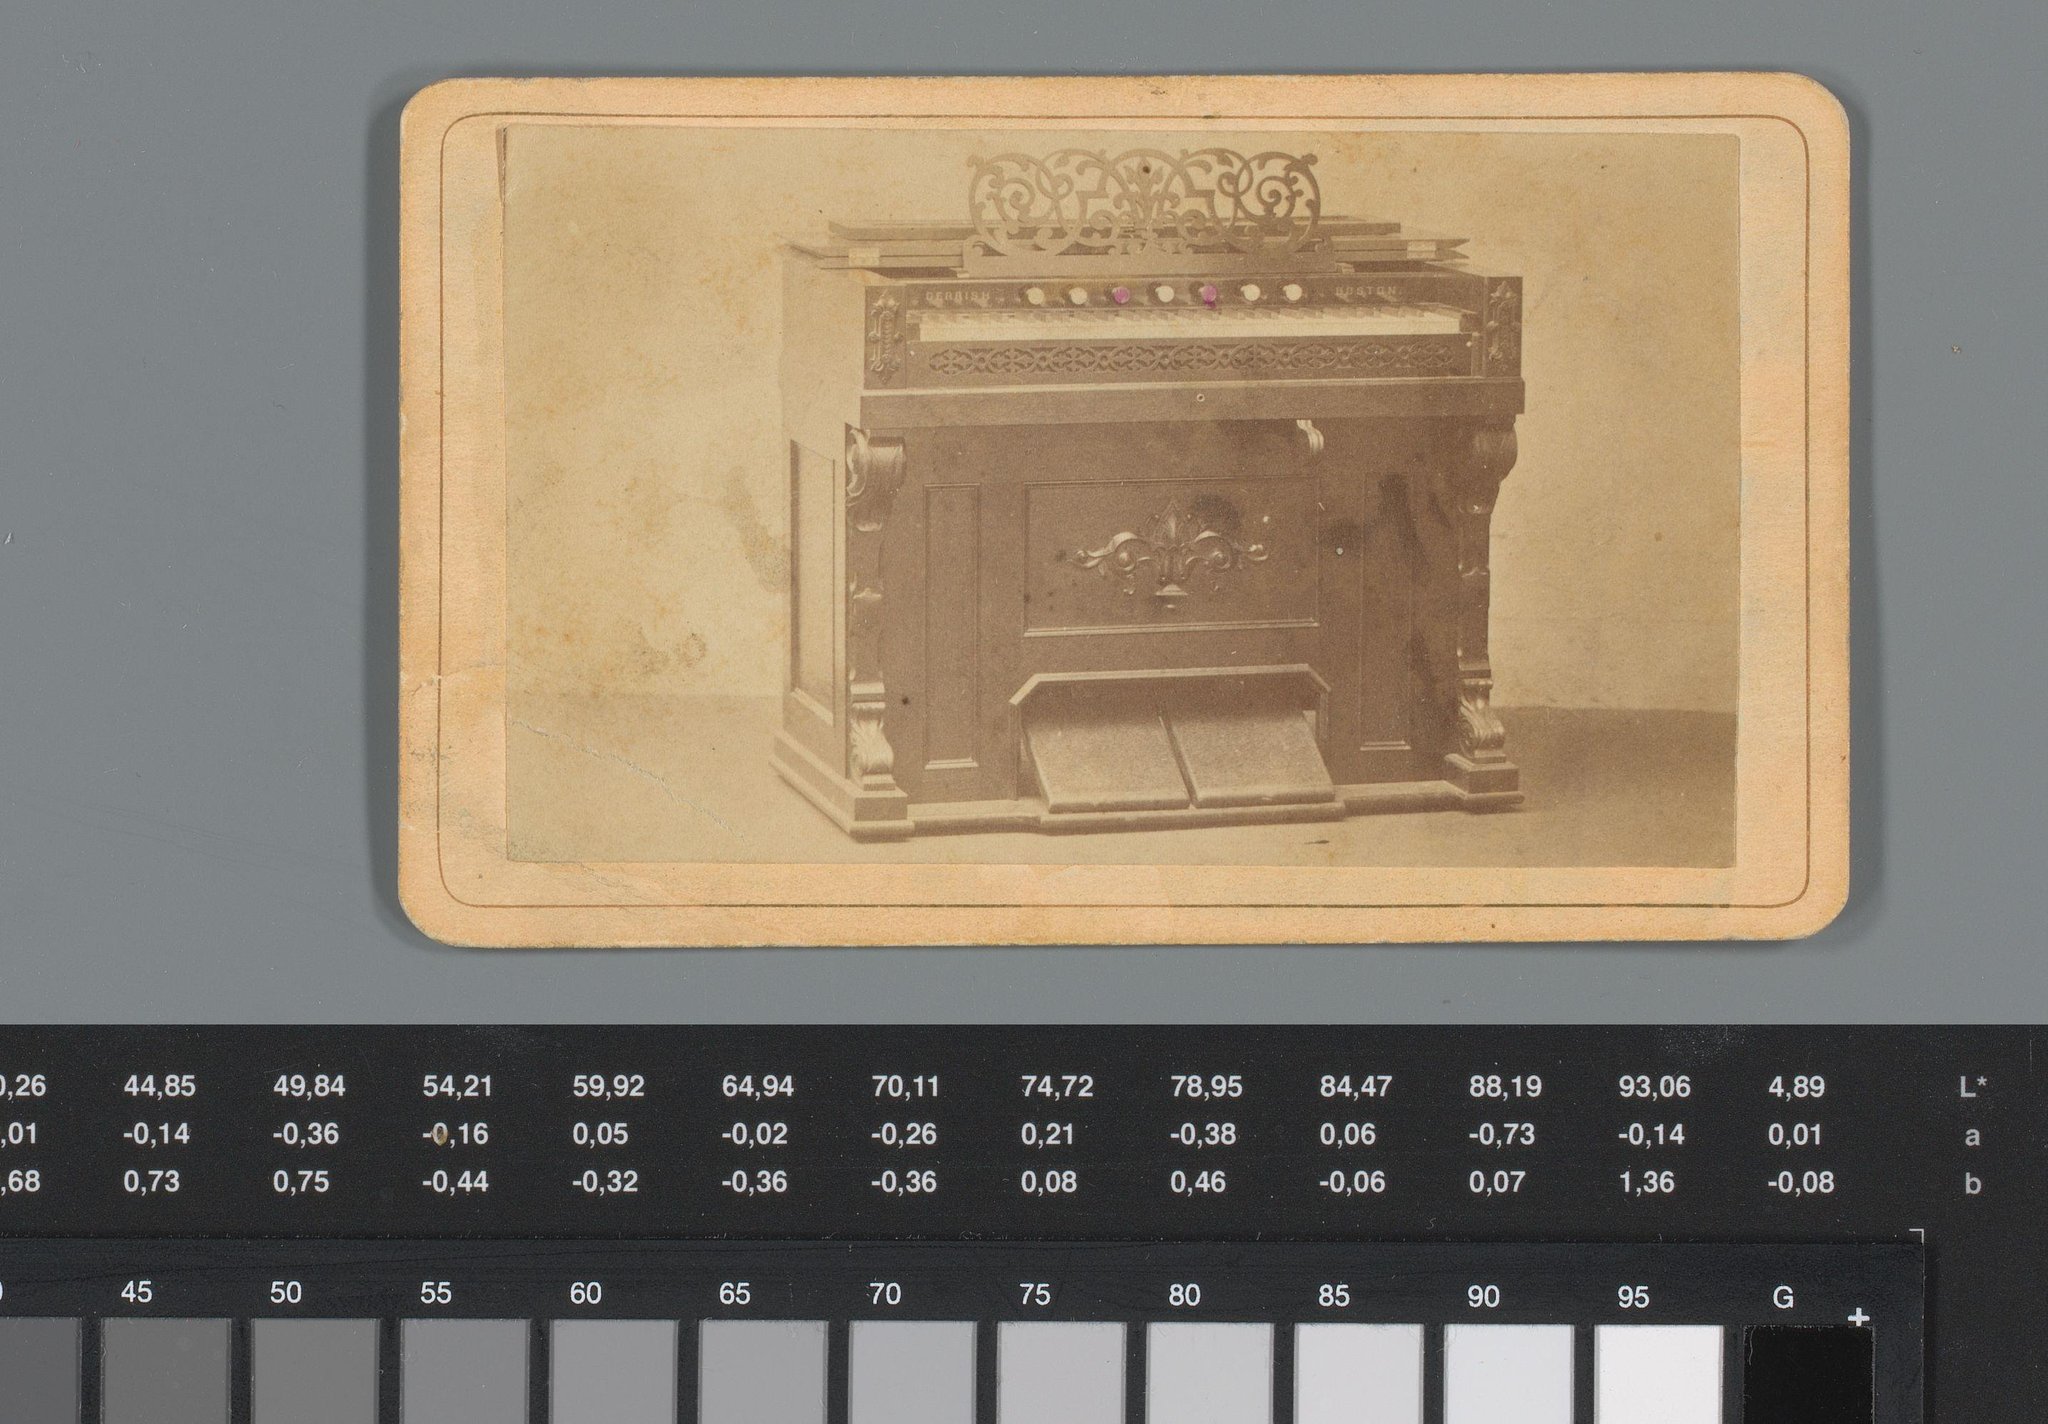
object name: photograph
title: Reclame voor orgels van William H. Gerrish te Boston met gezicht op een kabinetorgel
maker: Anonymous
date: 1850-1915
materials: cardboard, photographic support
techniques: albumen print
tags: advertising, organ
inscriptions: inscription: ‘The Gerrish Cabinet Organ, (...) BOSTON.’